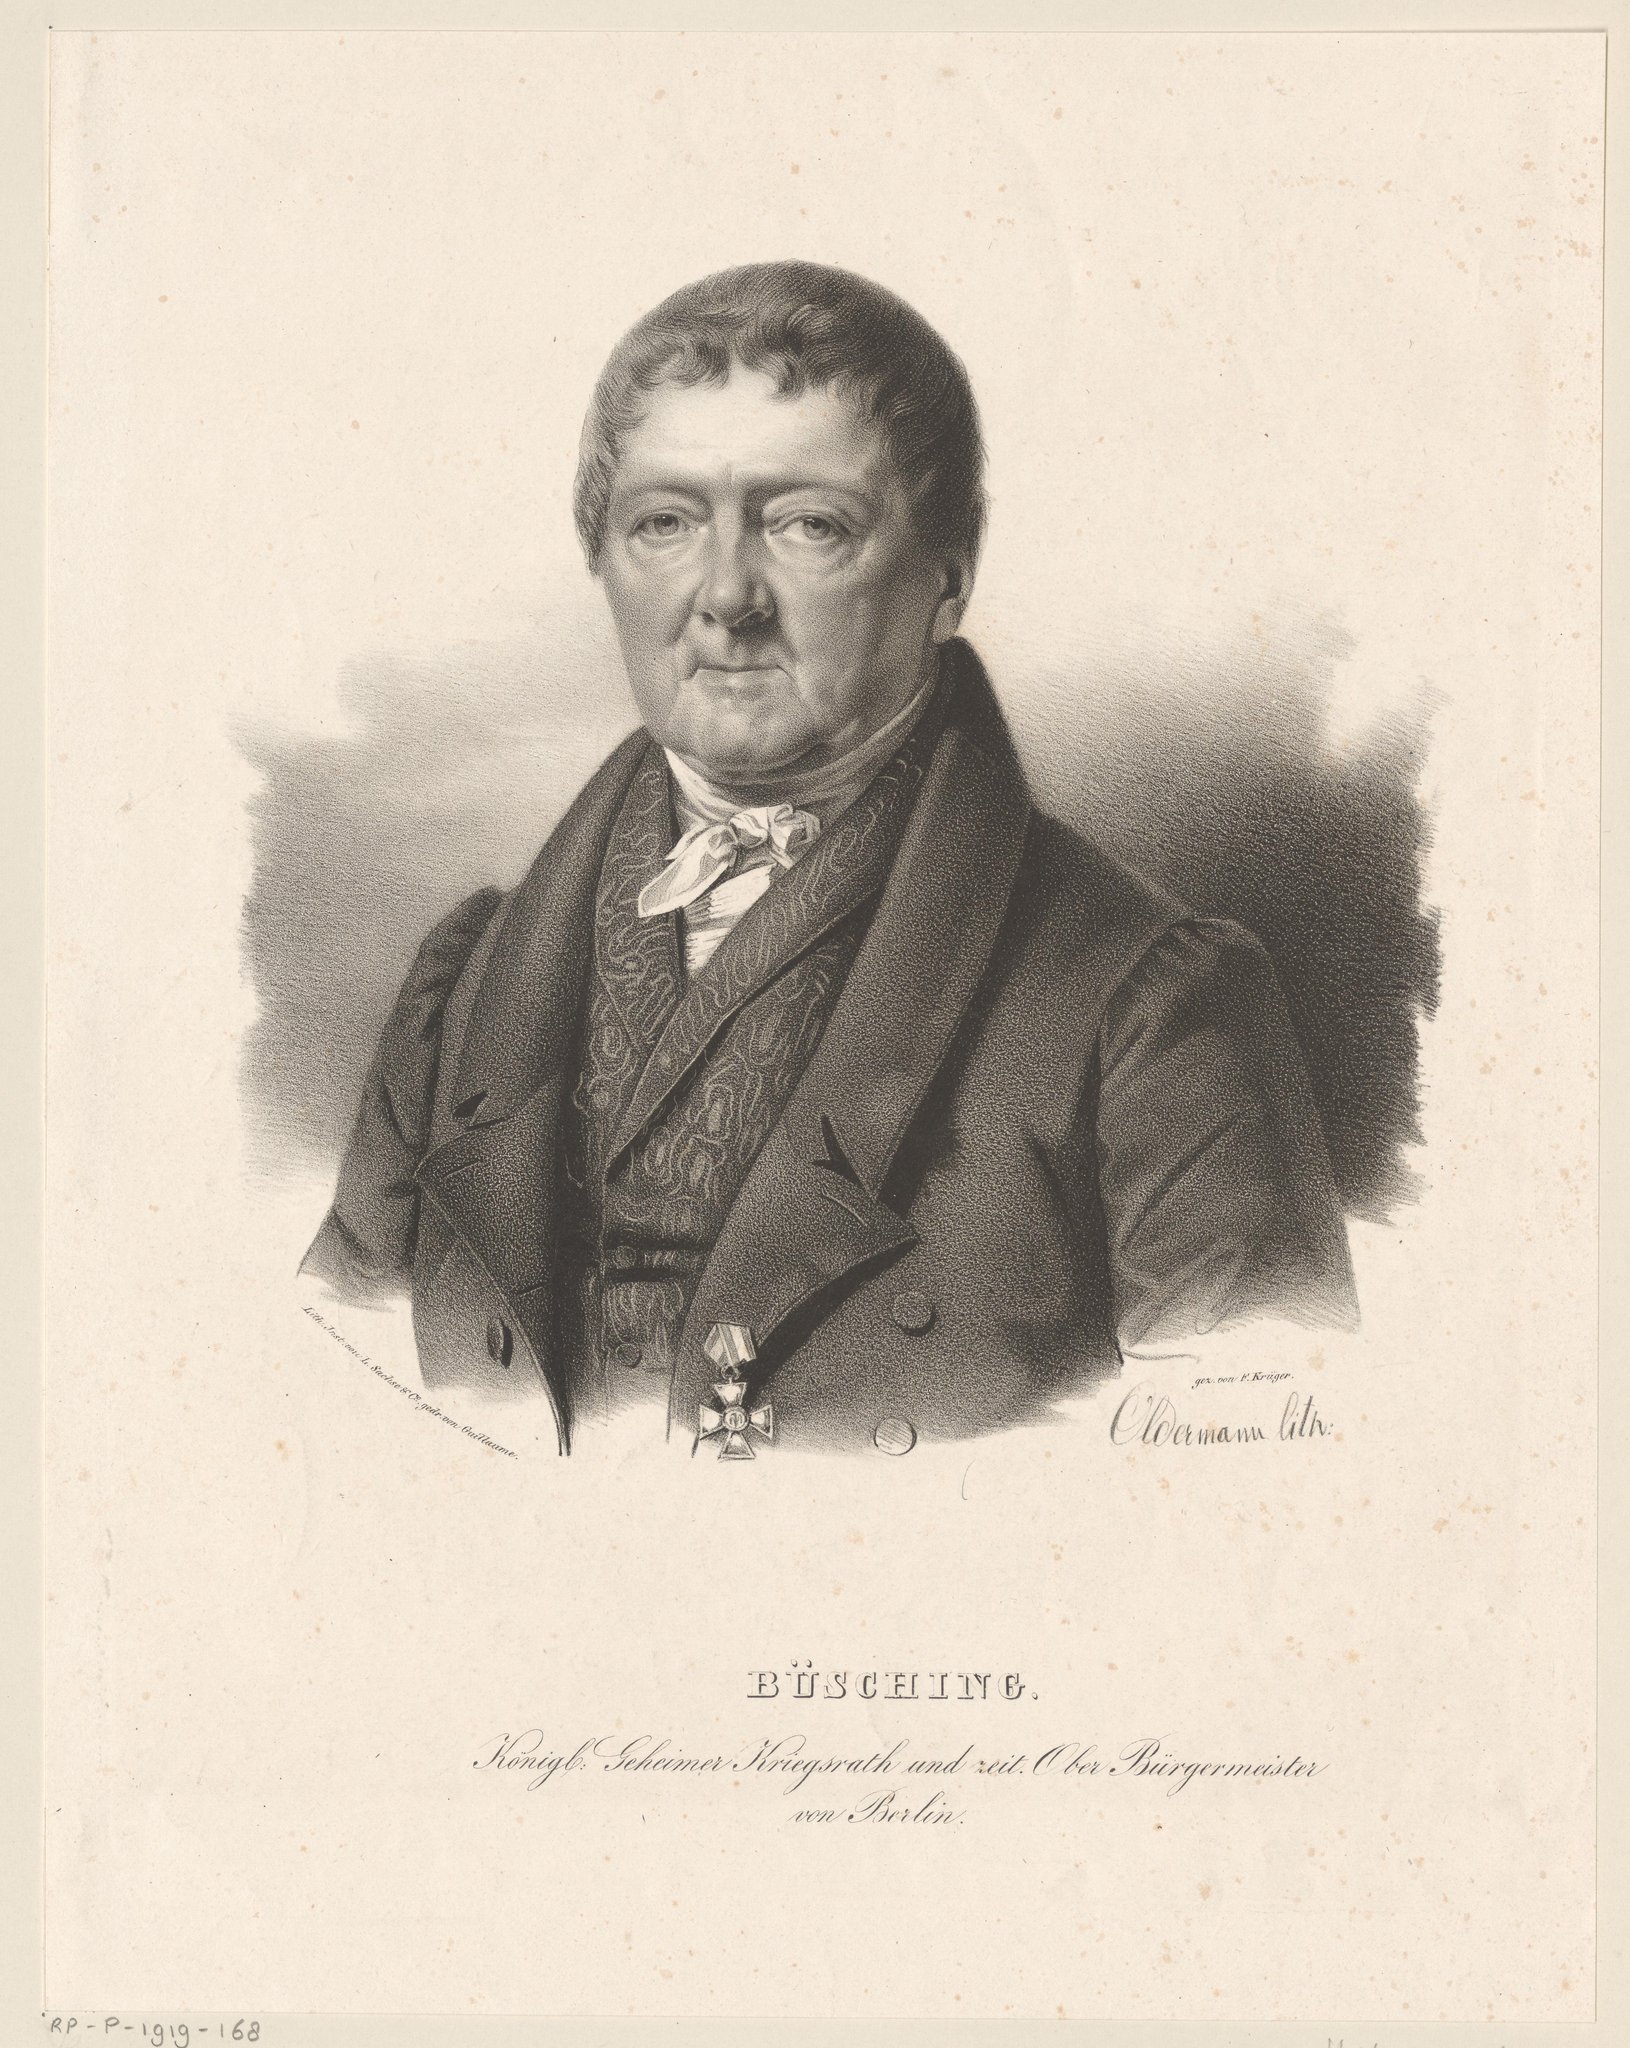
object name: print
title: Portret van Johann Stephan Gottfried Büsching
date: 1832-1854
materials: paper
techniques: lithograph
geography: berlin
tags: berlin, mayor, mayor, burgomaster, historical persons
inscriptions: collector's mark: Lugt 2228